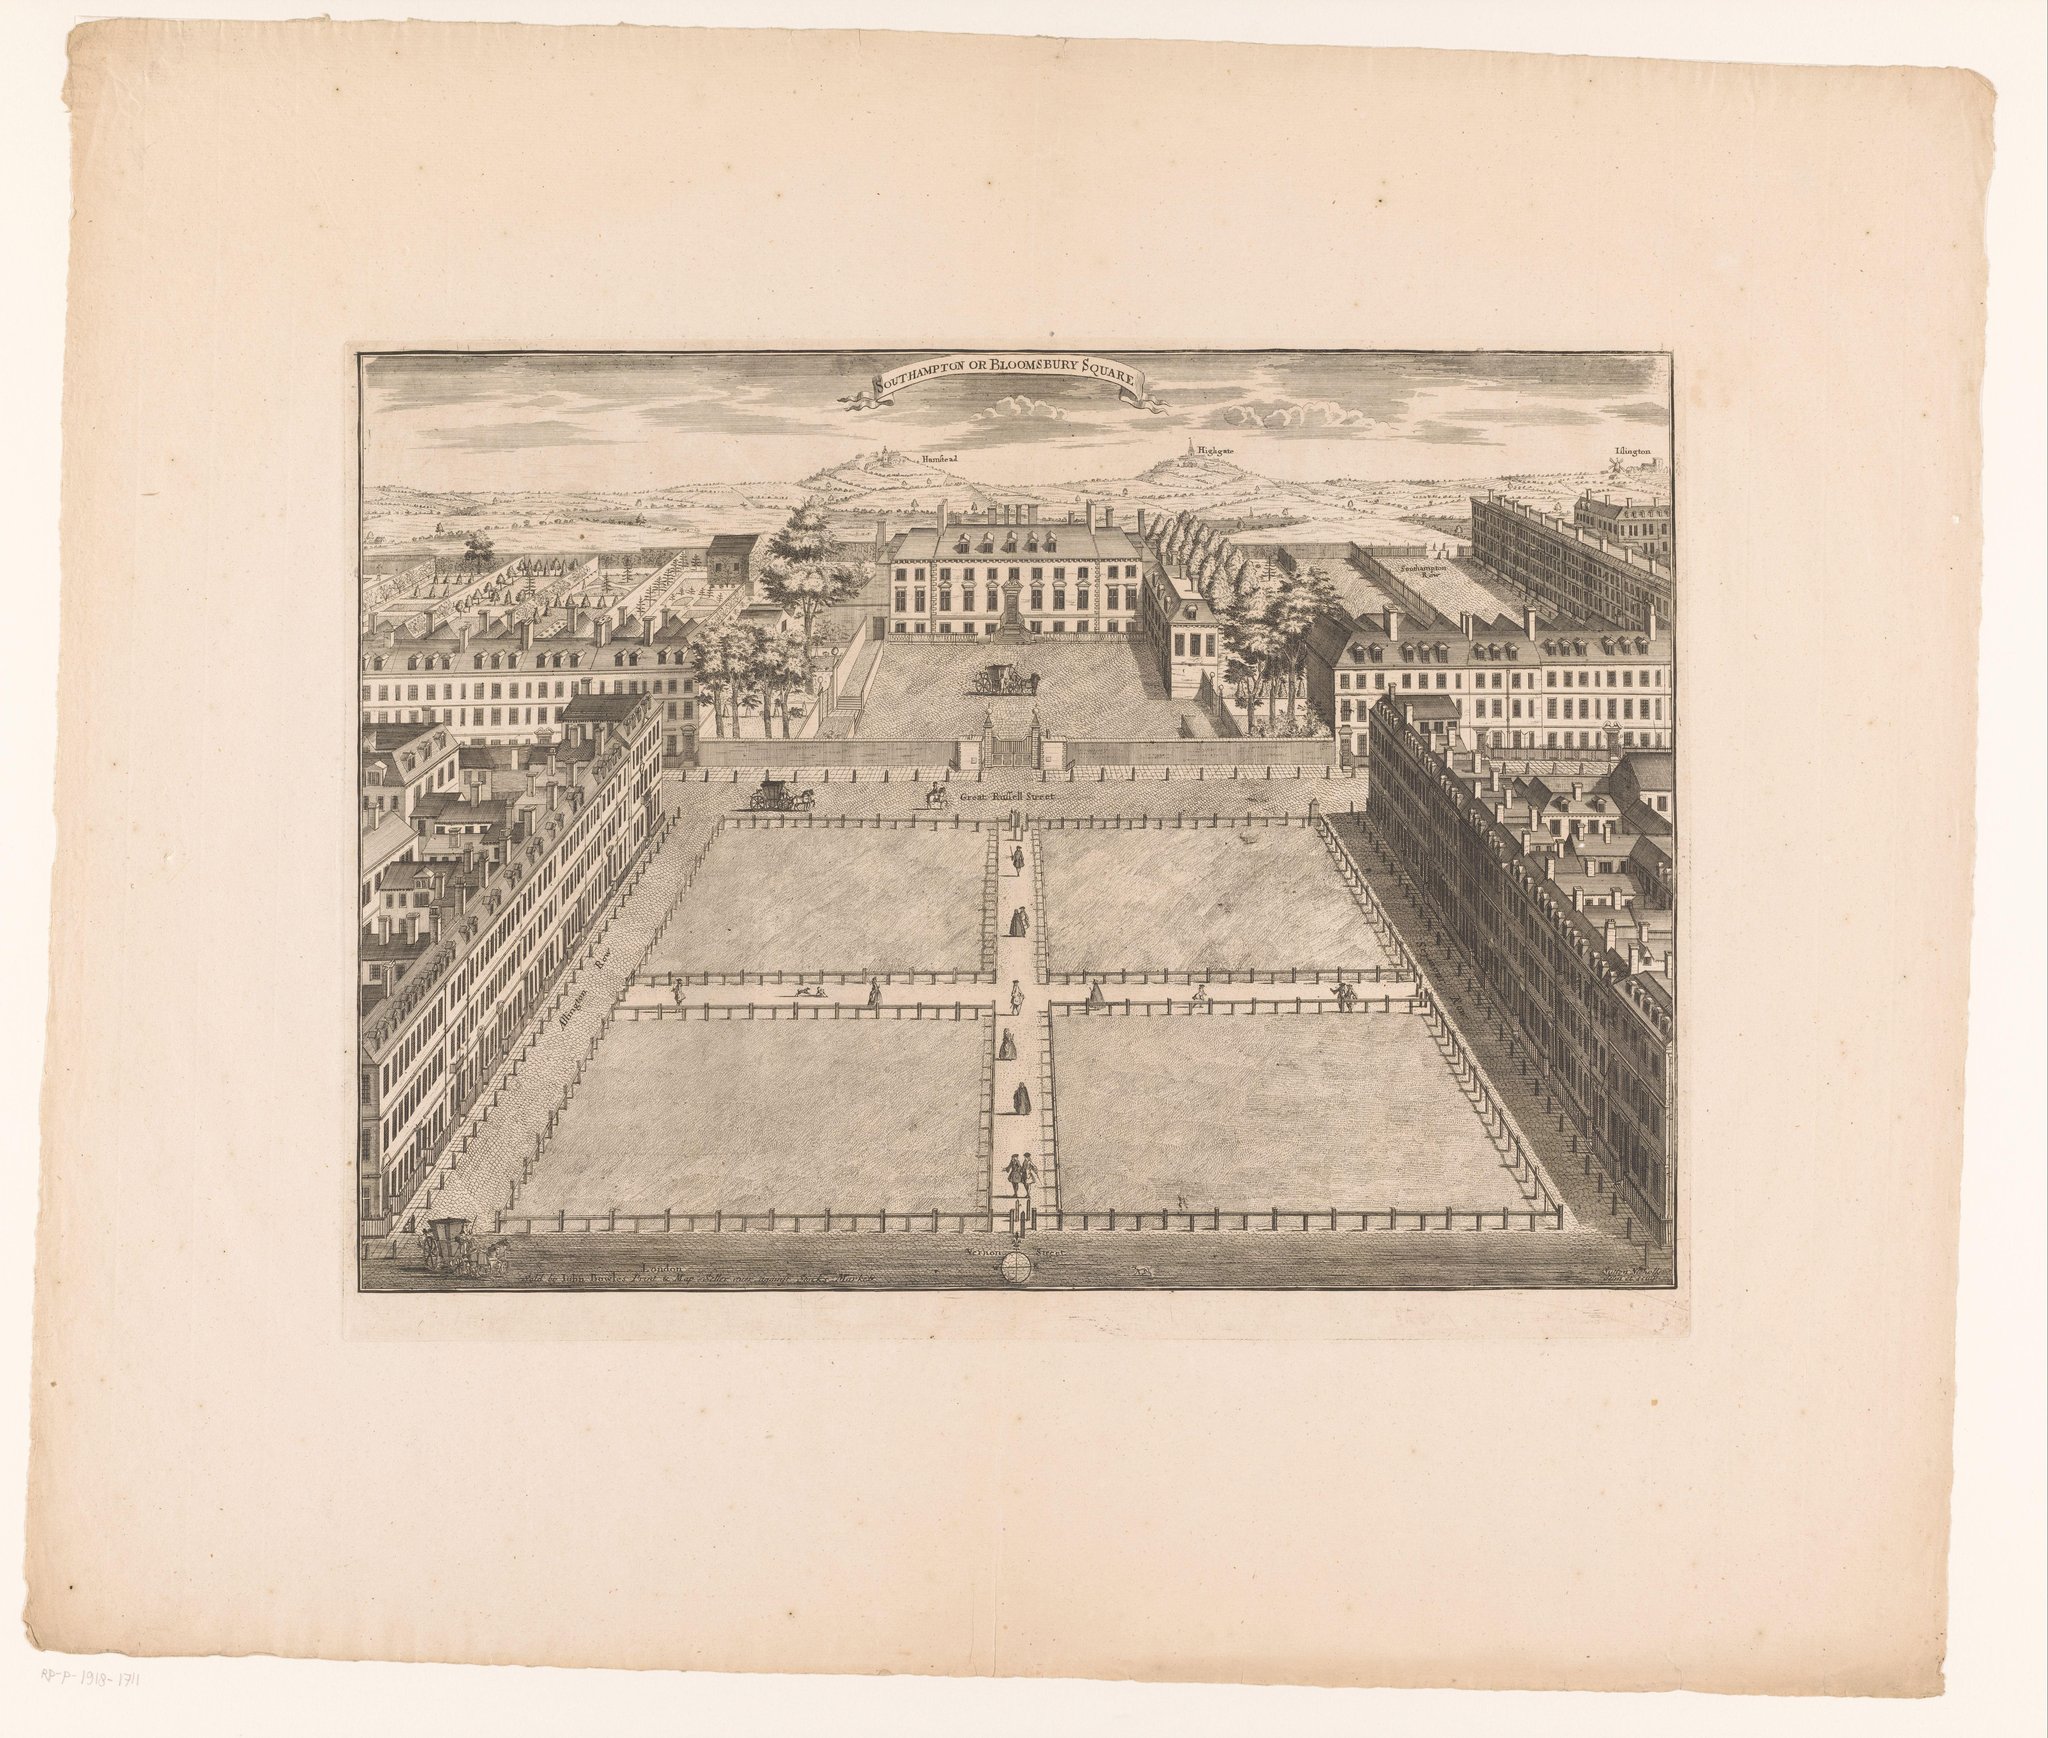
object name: print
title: Gezicht op Bloomsbury Square in Londen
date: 1720-1731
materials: paper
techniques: engraving, etching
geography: london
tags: square, place, circus, etc. (+ city(-scape) with figures, staffage)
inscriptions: collector's mark: Lugt 2233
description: Deze reeks werd voor het eerst compleet uitgegeven in 1731, al zijn de losse prenten al voor die tijd uitgebracht. De meeste prenten zijn vervaardigd door Sutton Nicholls. De serie werd aangeboden voor verkoop door John Bowles in zijn catalogus 1753, op pagina 76, nummer 16.